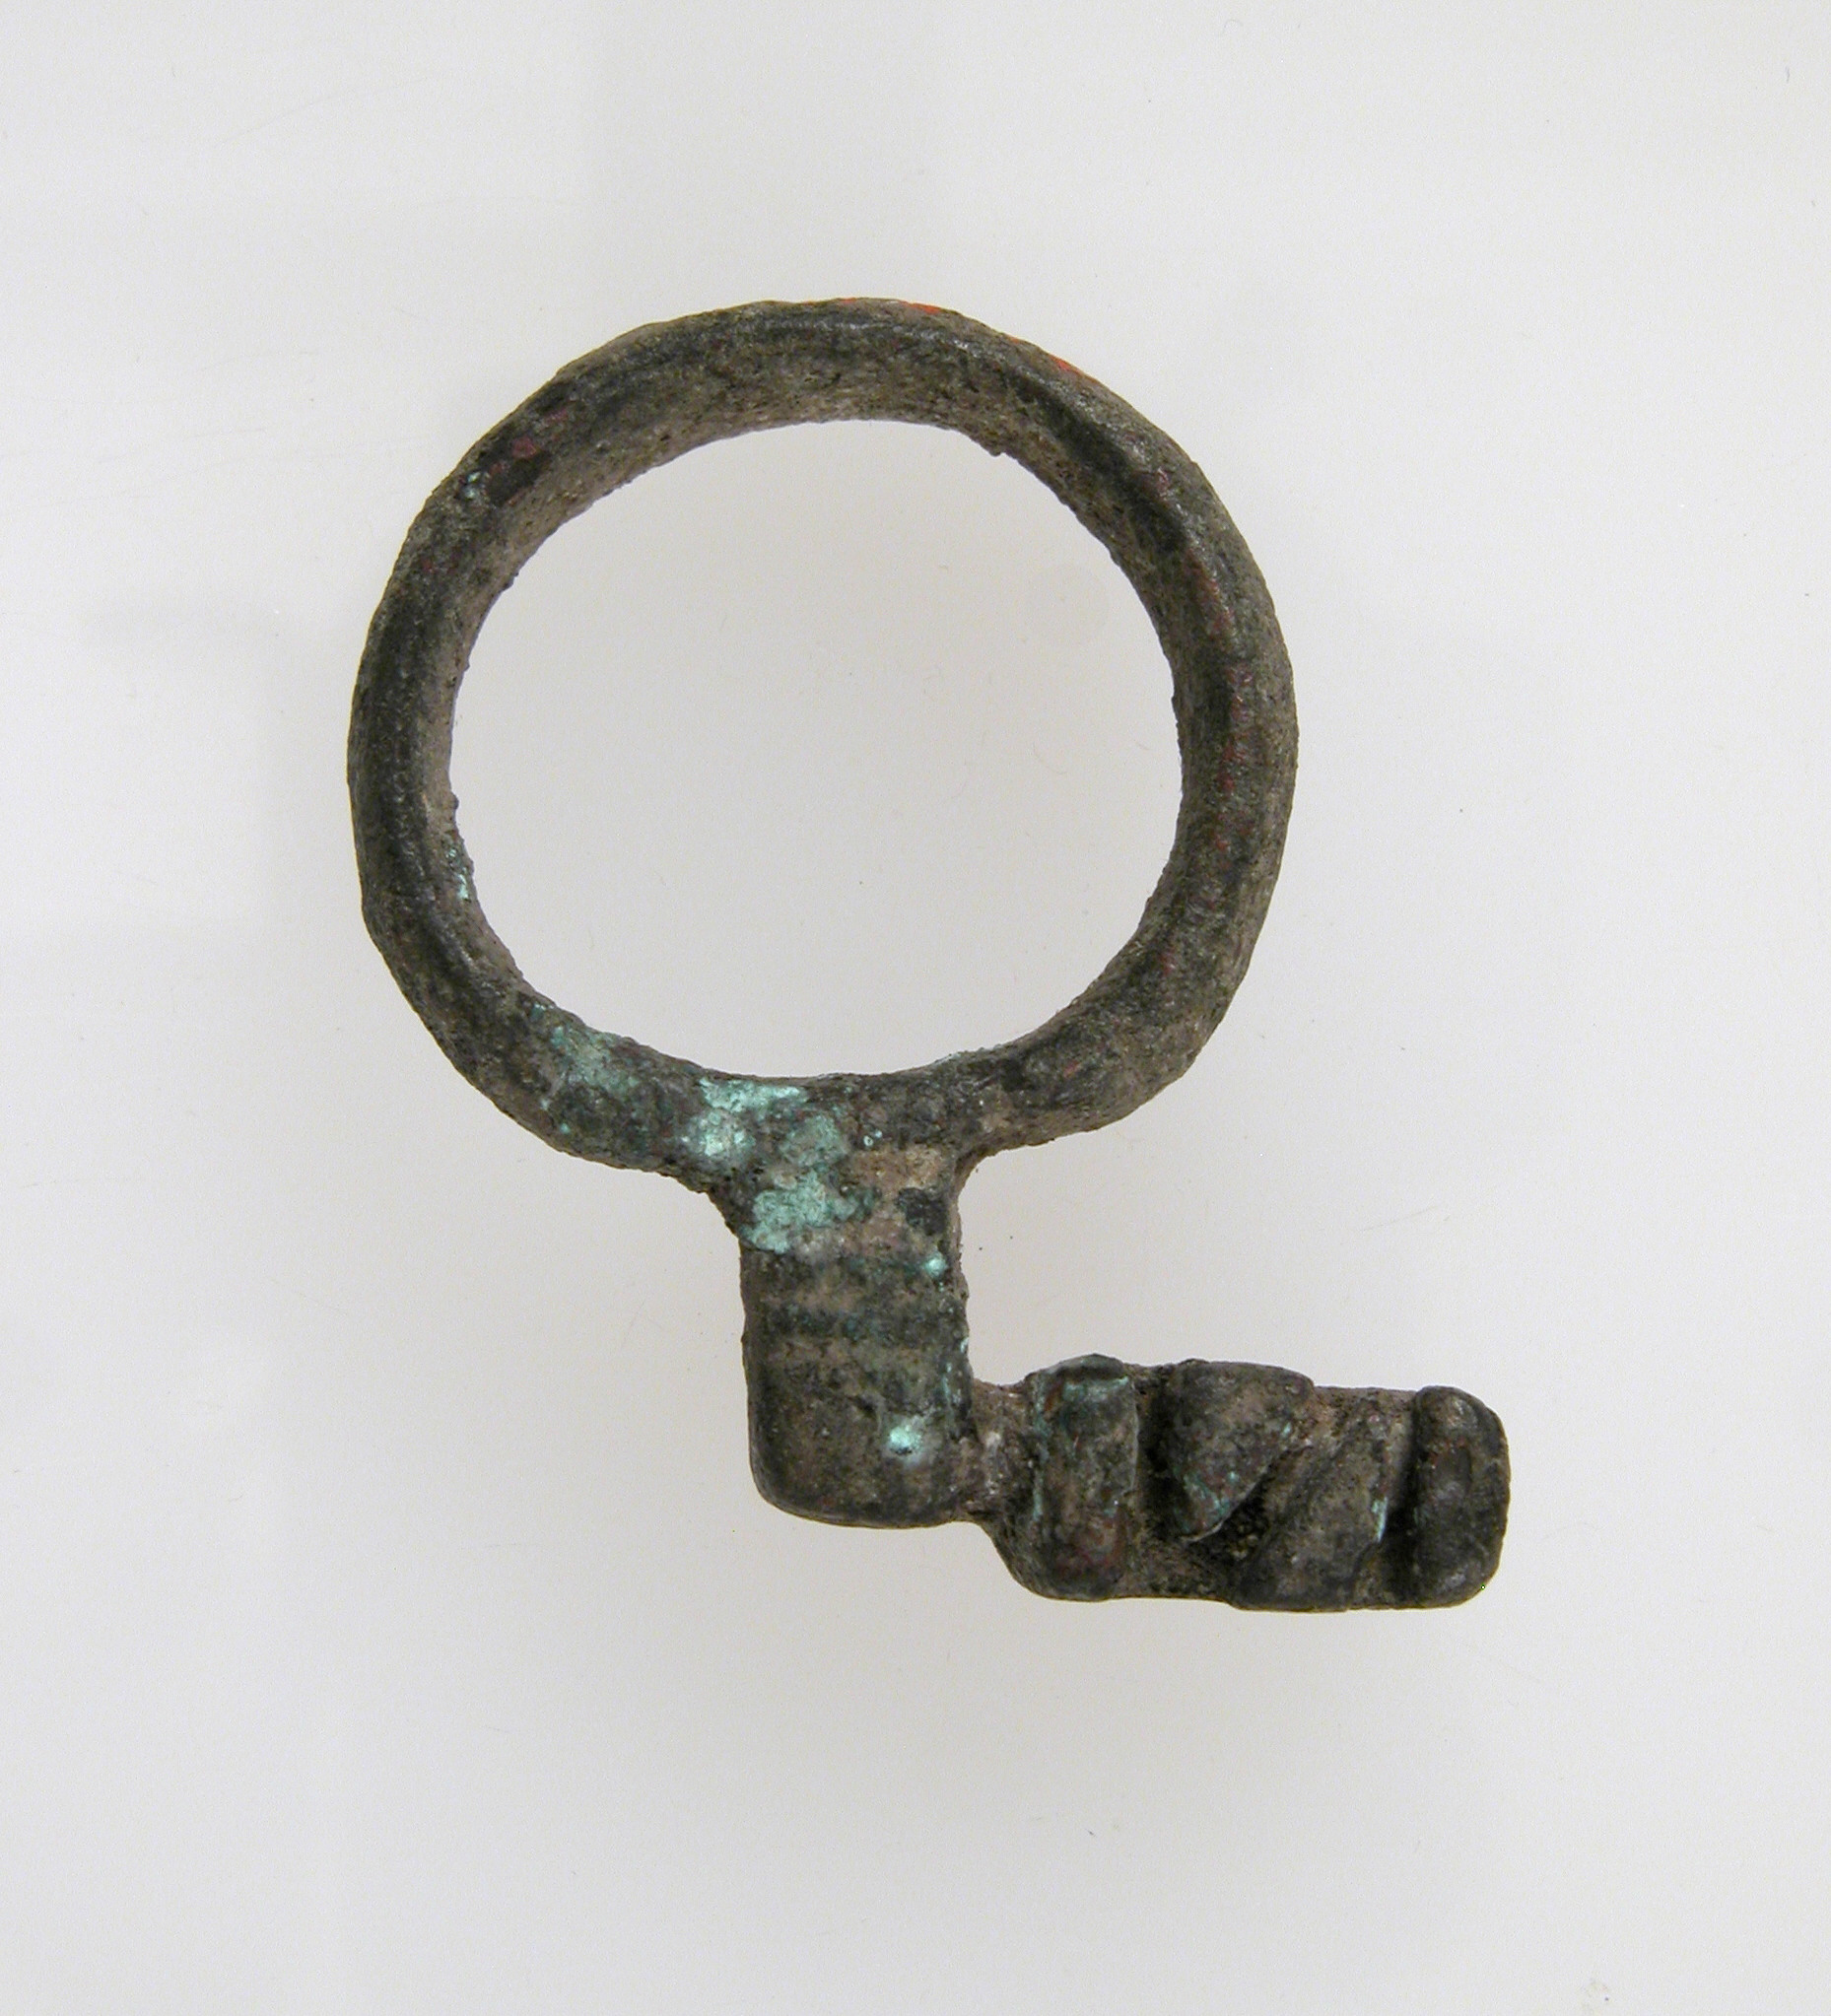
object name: key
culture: roman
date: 1-700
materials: copper alloy